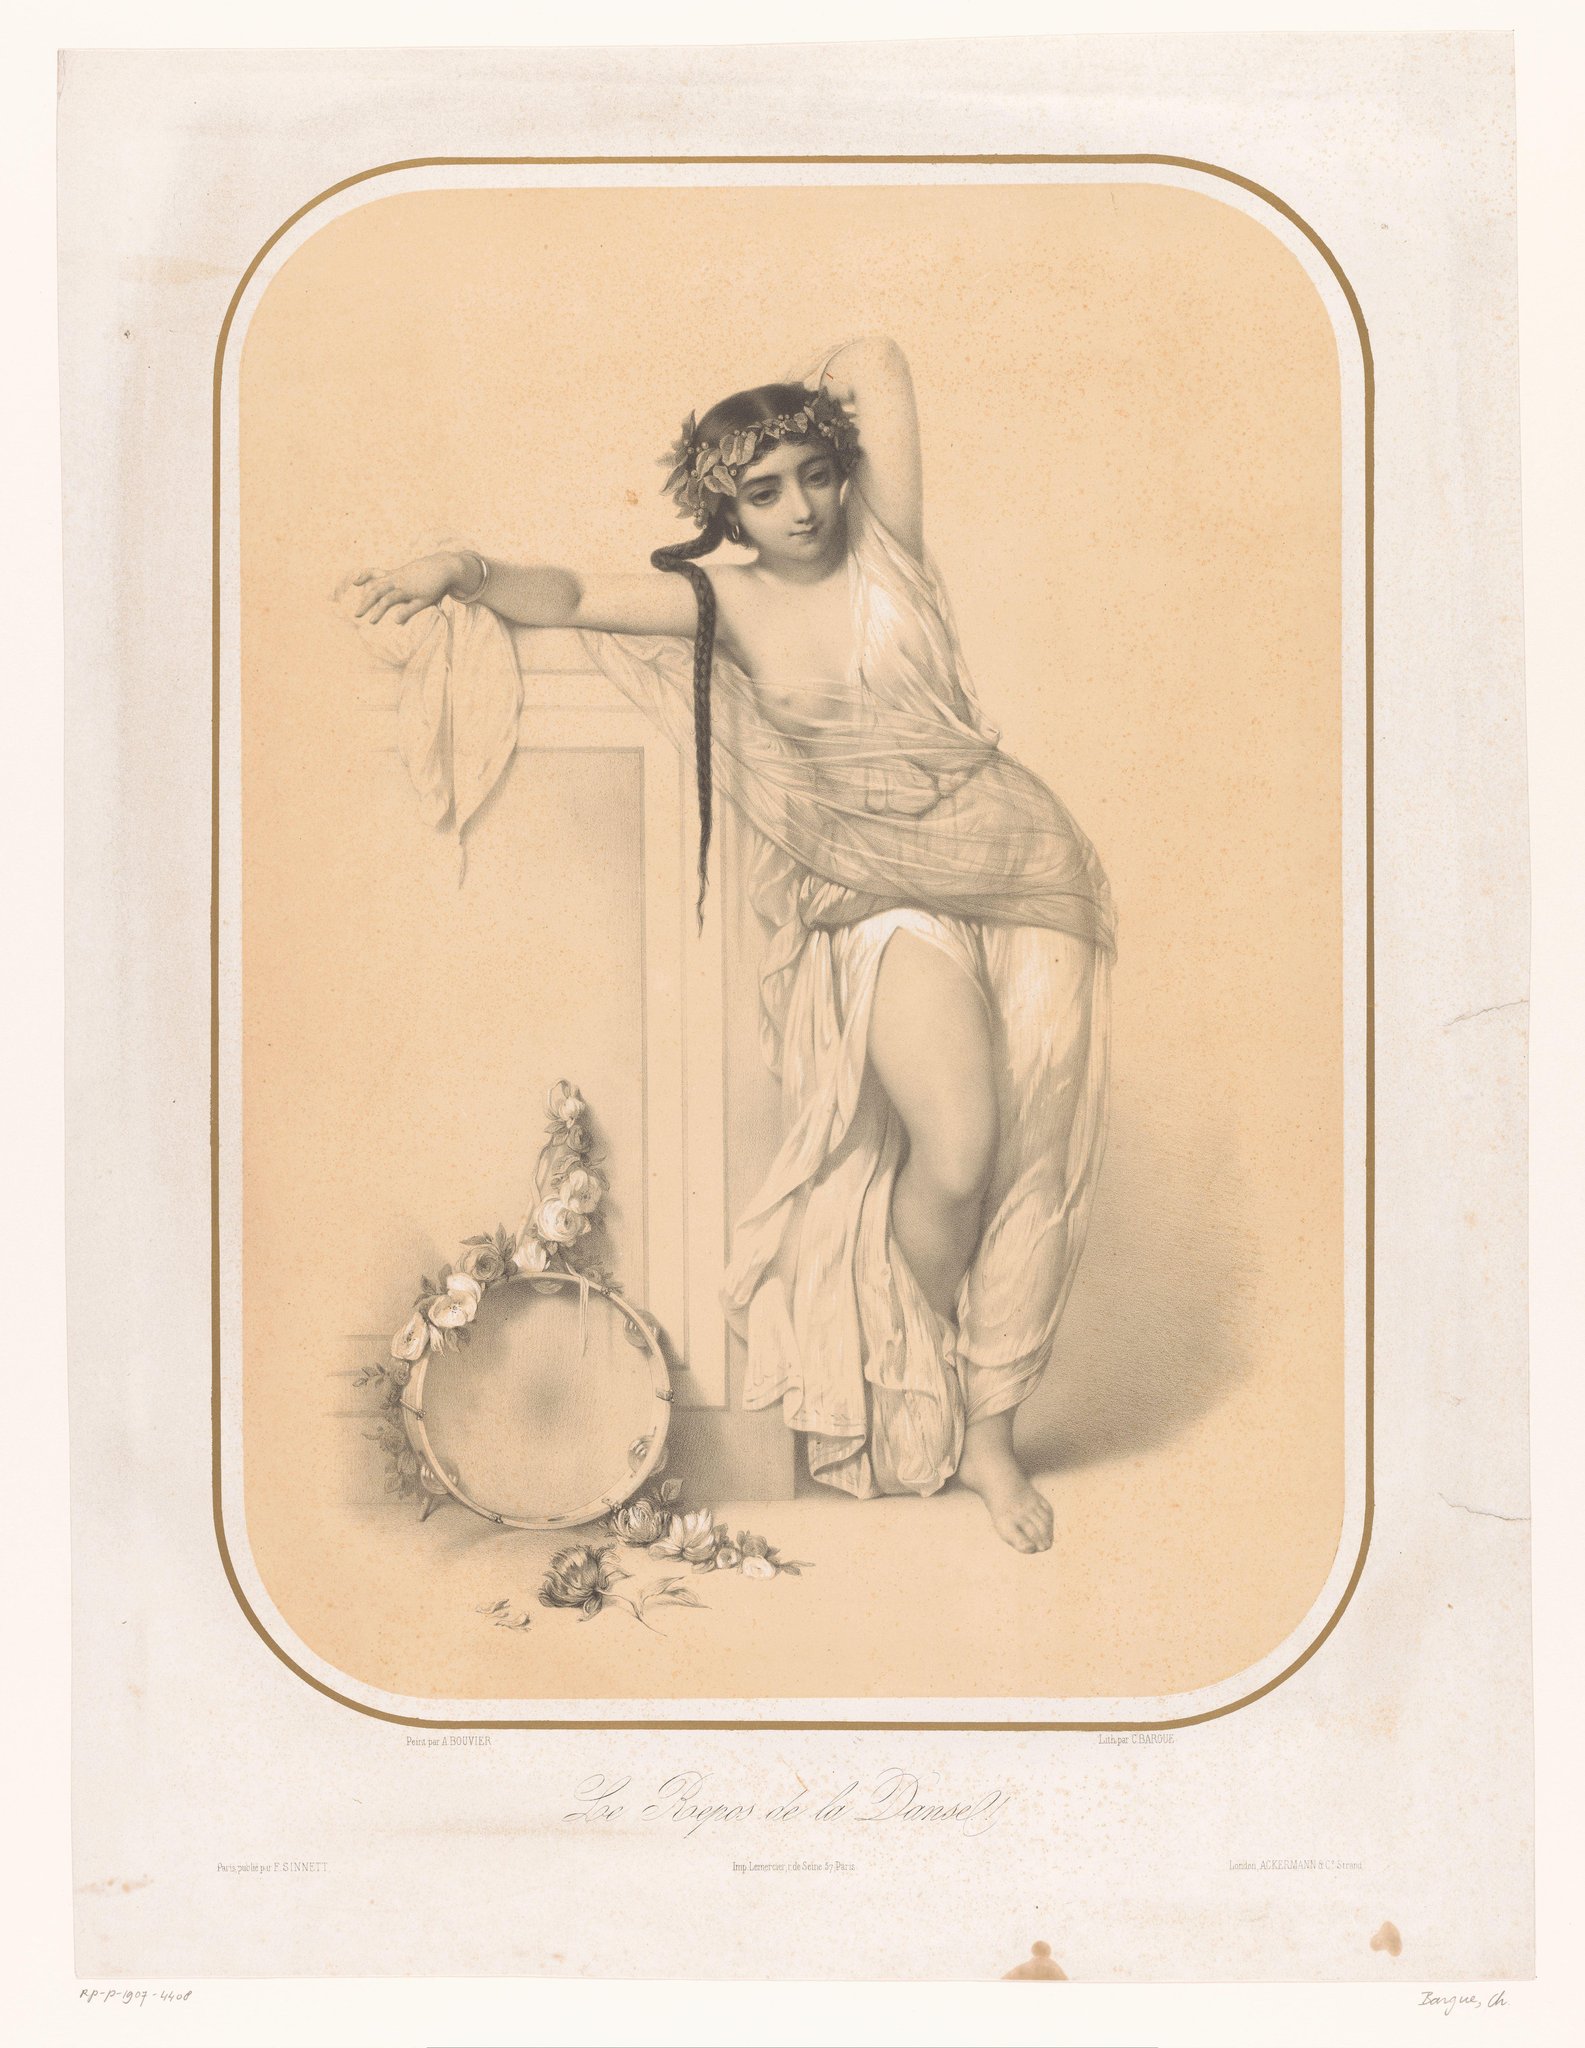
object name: print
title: Meisje met tamboerijn rust uit van het dansen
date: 1852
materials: paper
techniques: tone lithography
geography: paris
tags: adolescent, young woman, maiden, tambourine, female dancer, resting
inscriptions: collector's mark: Lugt 2228a